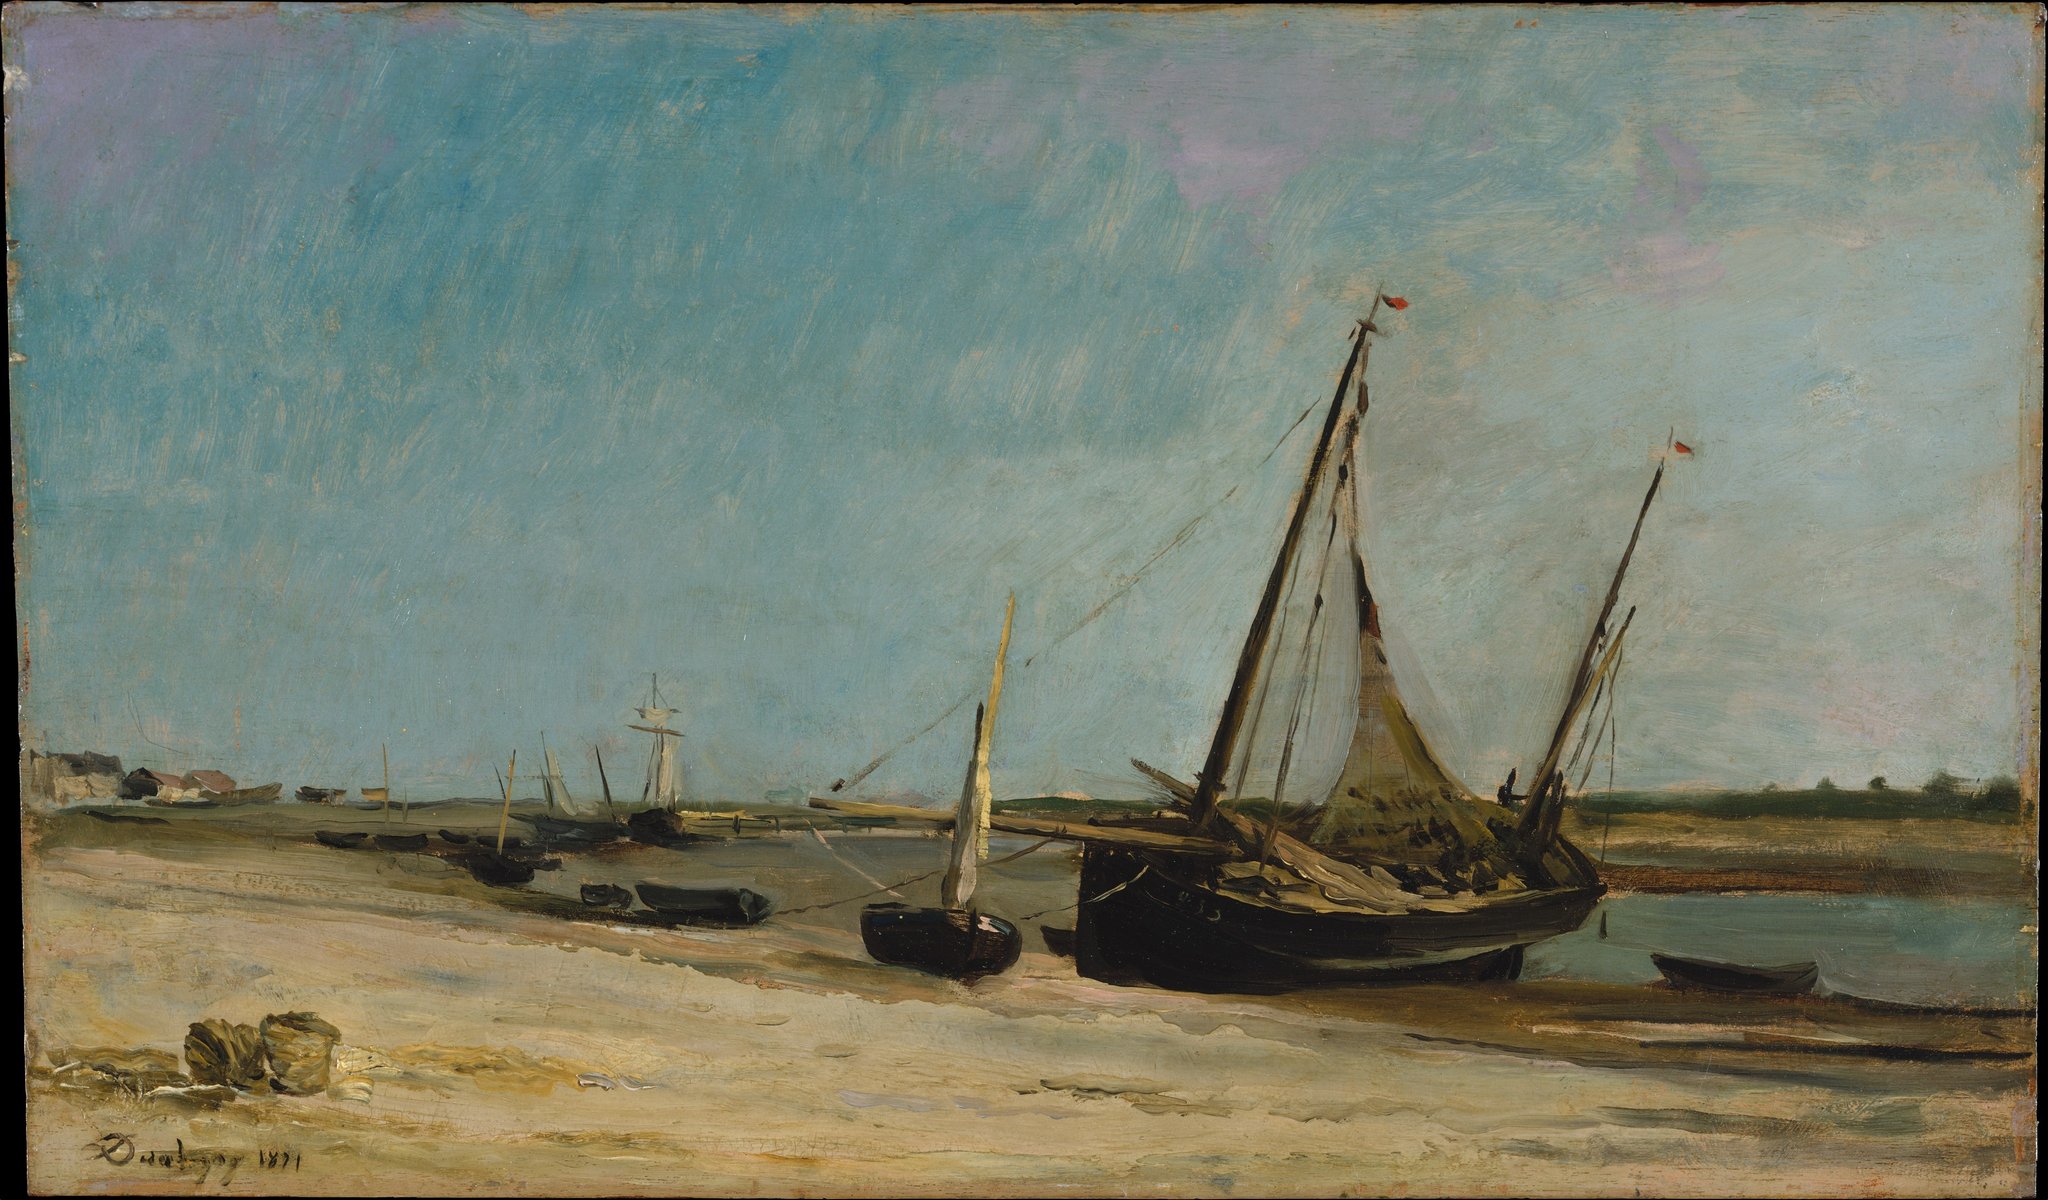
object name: painting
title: Boats on the Seacoast at Etaples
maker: charles-françois daubigny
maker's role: artist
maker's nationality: french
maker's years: 1817-1878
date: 1871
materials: oil, wood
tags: seascapes,boats